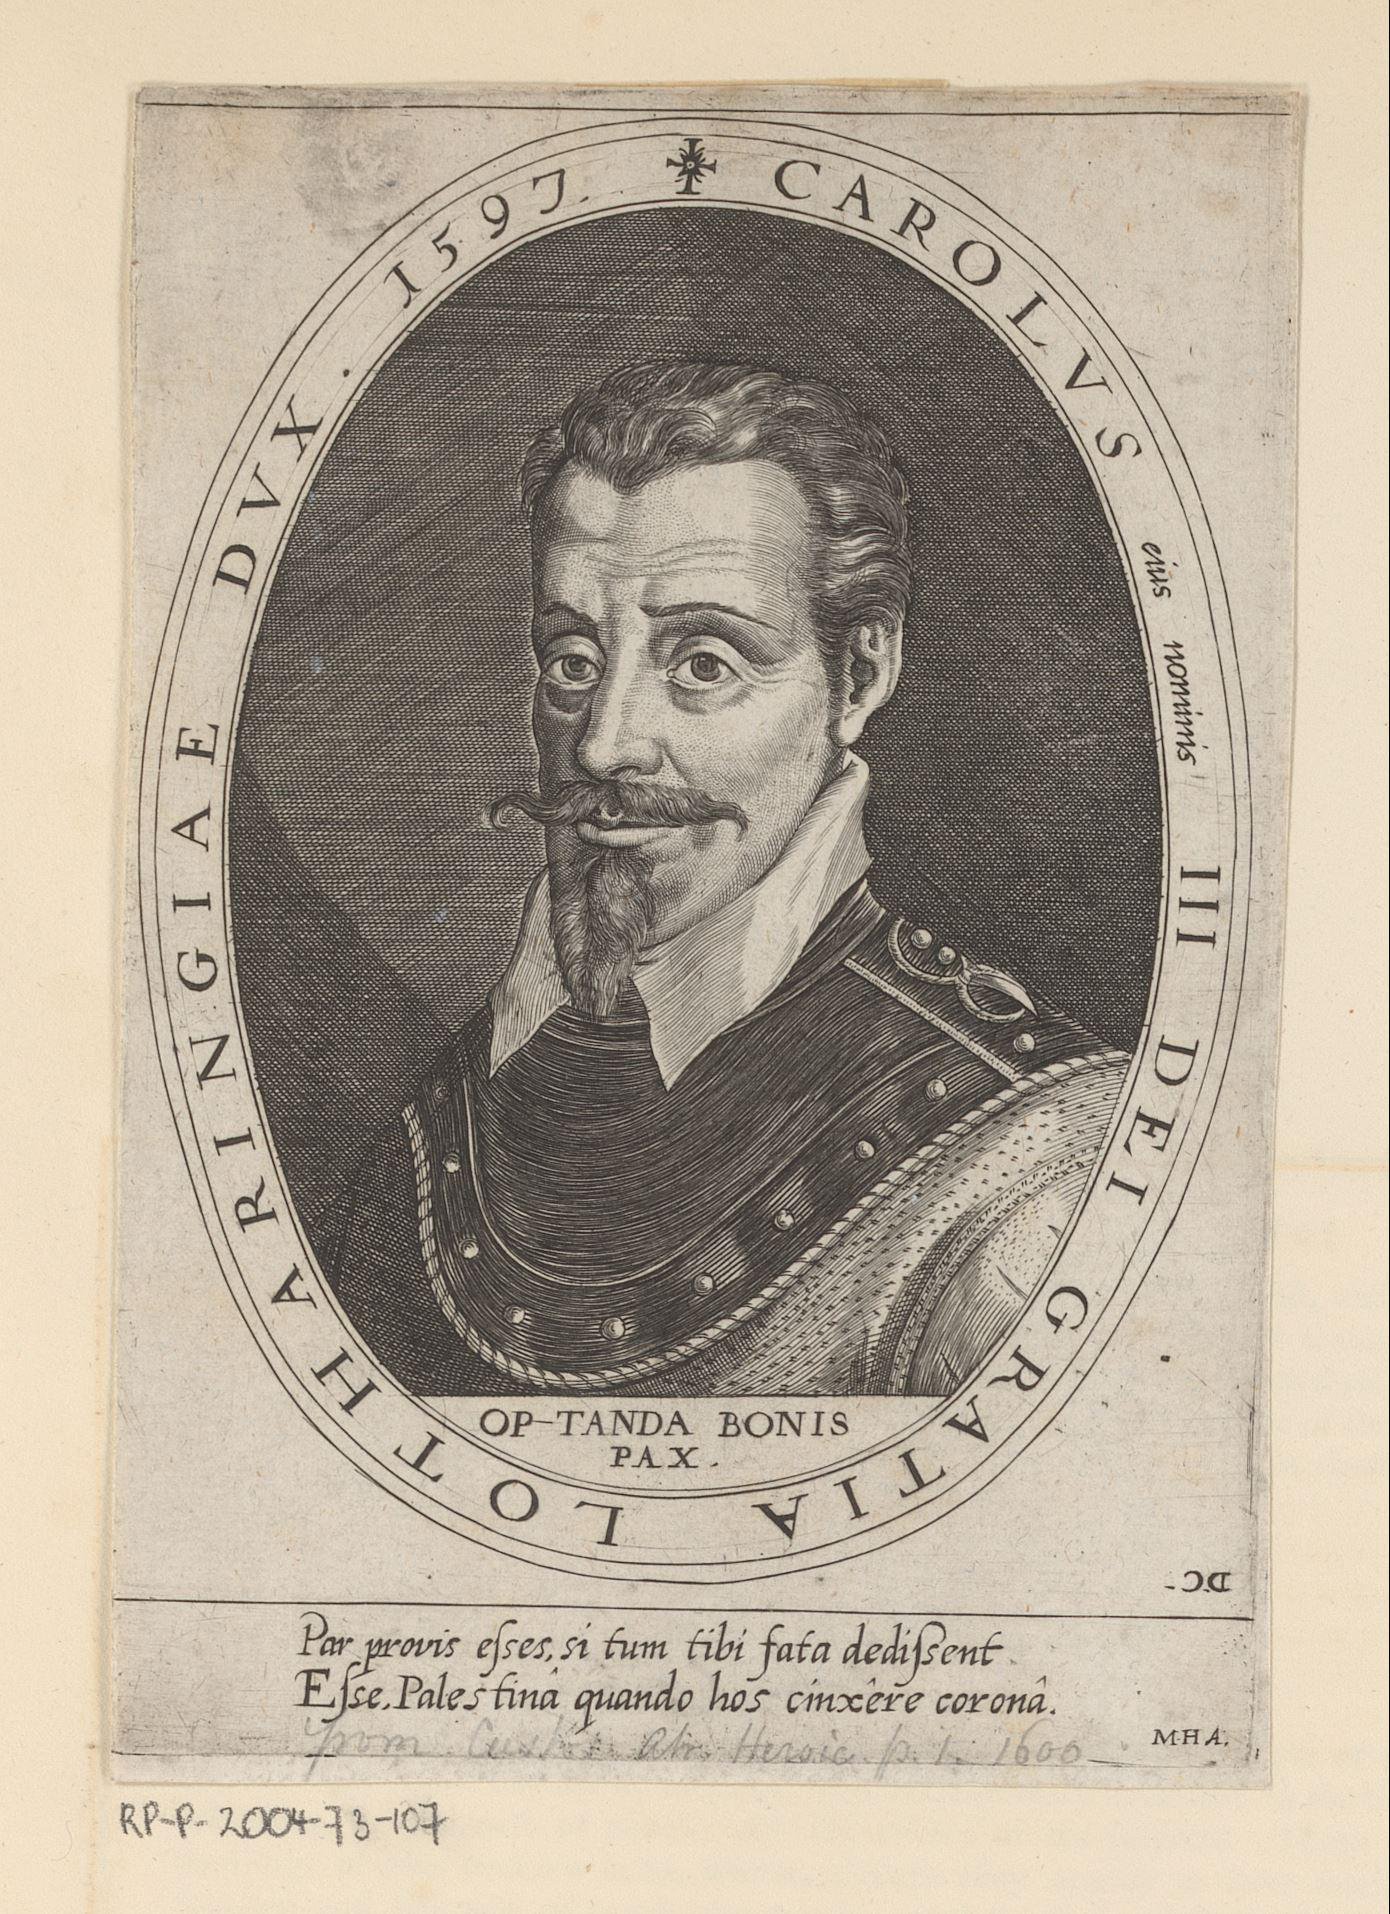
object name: album leaf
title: Portret van Karel III hertog van Lotharingen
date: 1597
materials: paper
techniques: engraving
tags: historical persons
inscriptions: date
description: De samensteller heeft deze prent in het album geplakt als illustratie bij: Pilkington, Matthew en Johann Heinrich Füssli. A dictionary of painters, from the revival of the art to the present period. 4 dln. Londen: John Crowder, 1805, dl. 2, p. 303.